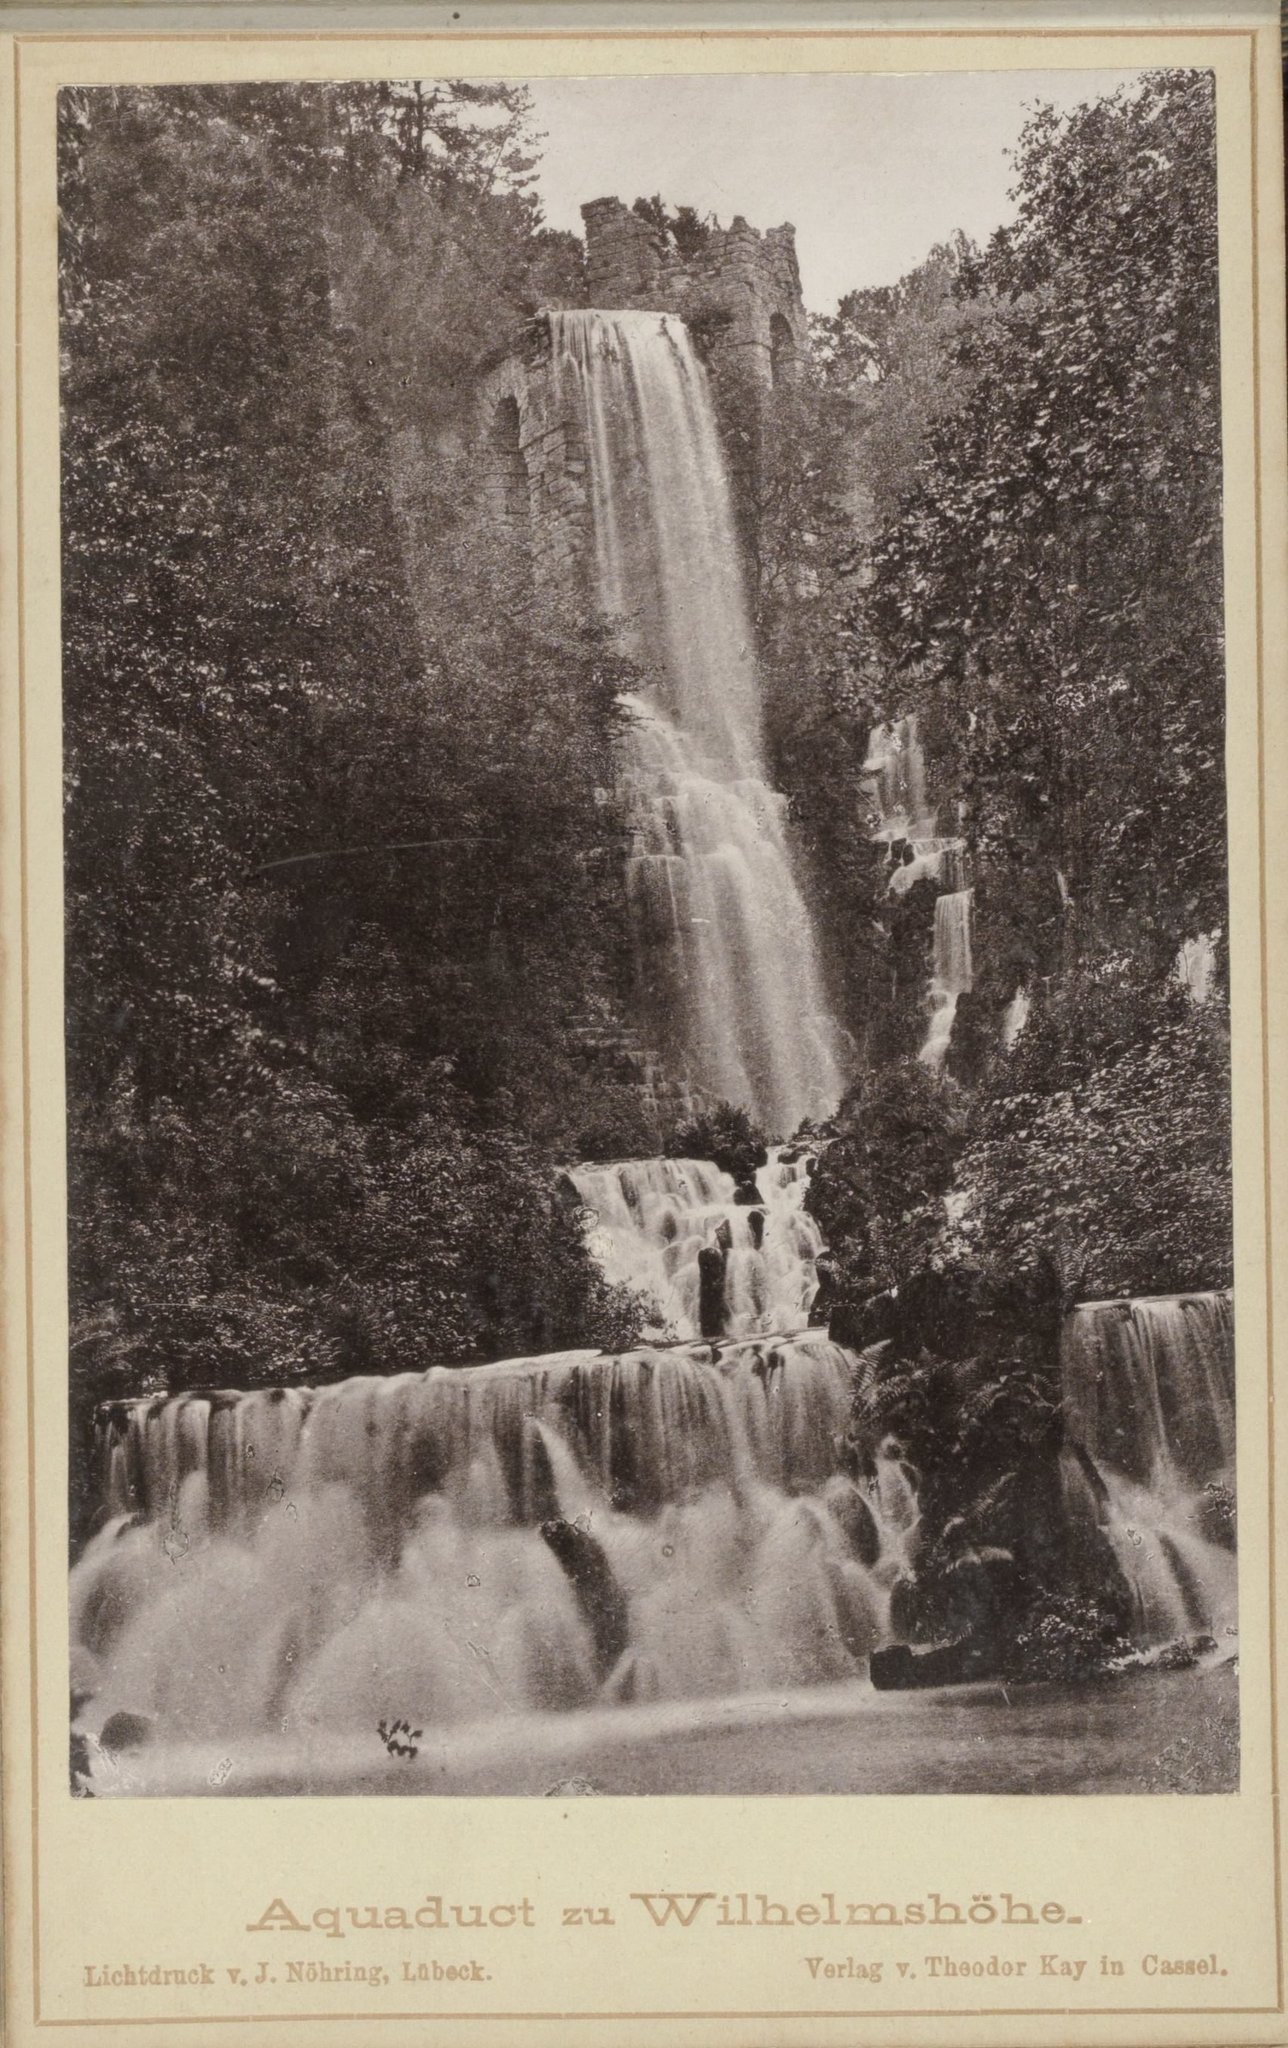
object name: photograph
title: Aquaduct zu Wilhelmshöhe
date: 1870-1890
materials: cardboard, paper, photographic support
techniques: photograph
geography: kassel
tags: waterfall, travelling; tourism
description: Onderdeel van Album met 38 foto's van een reis door de Harz.